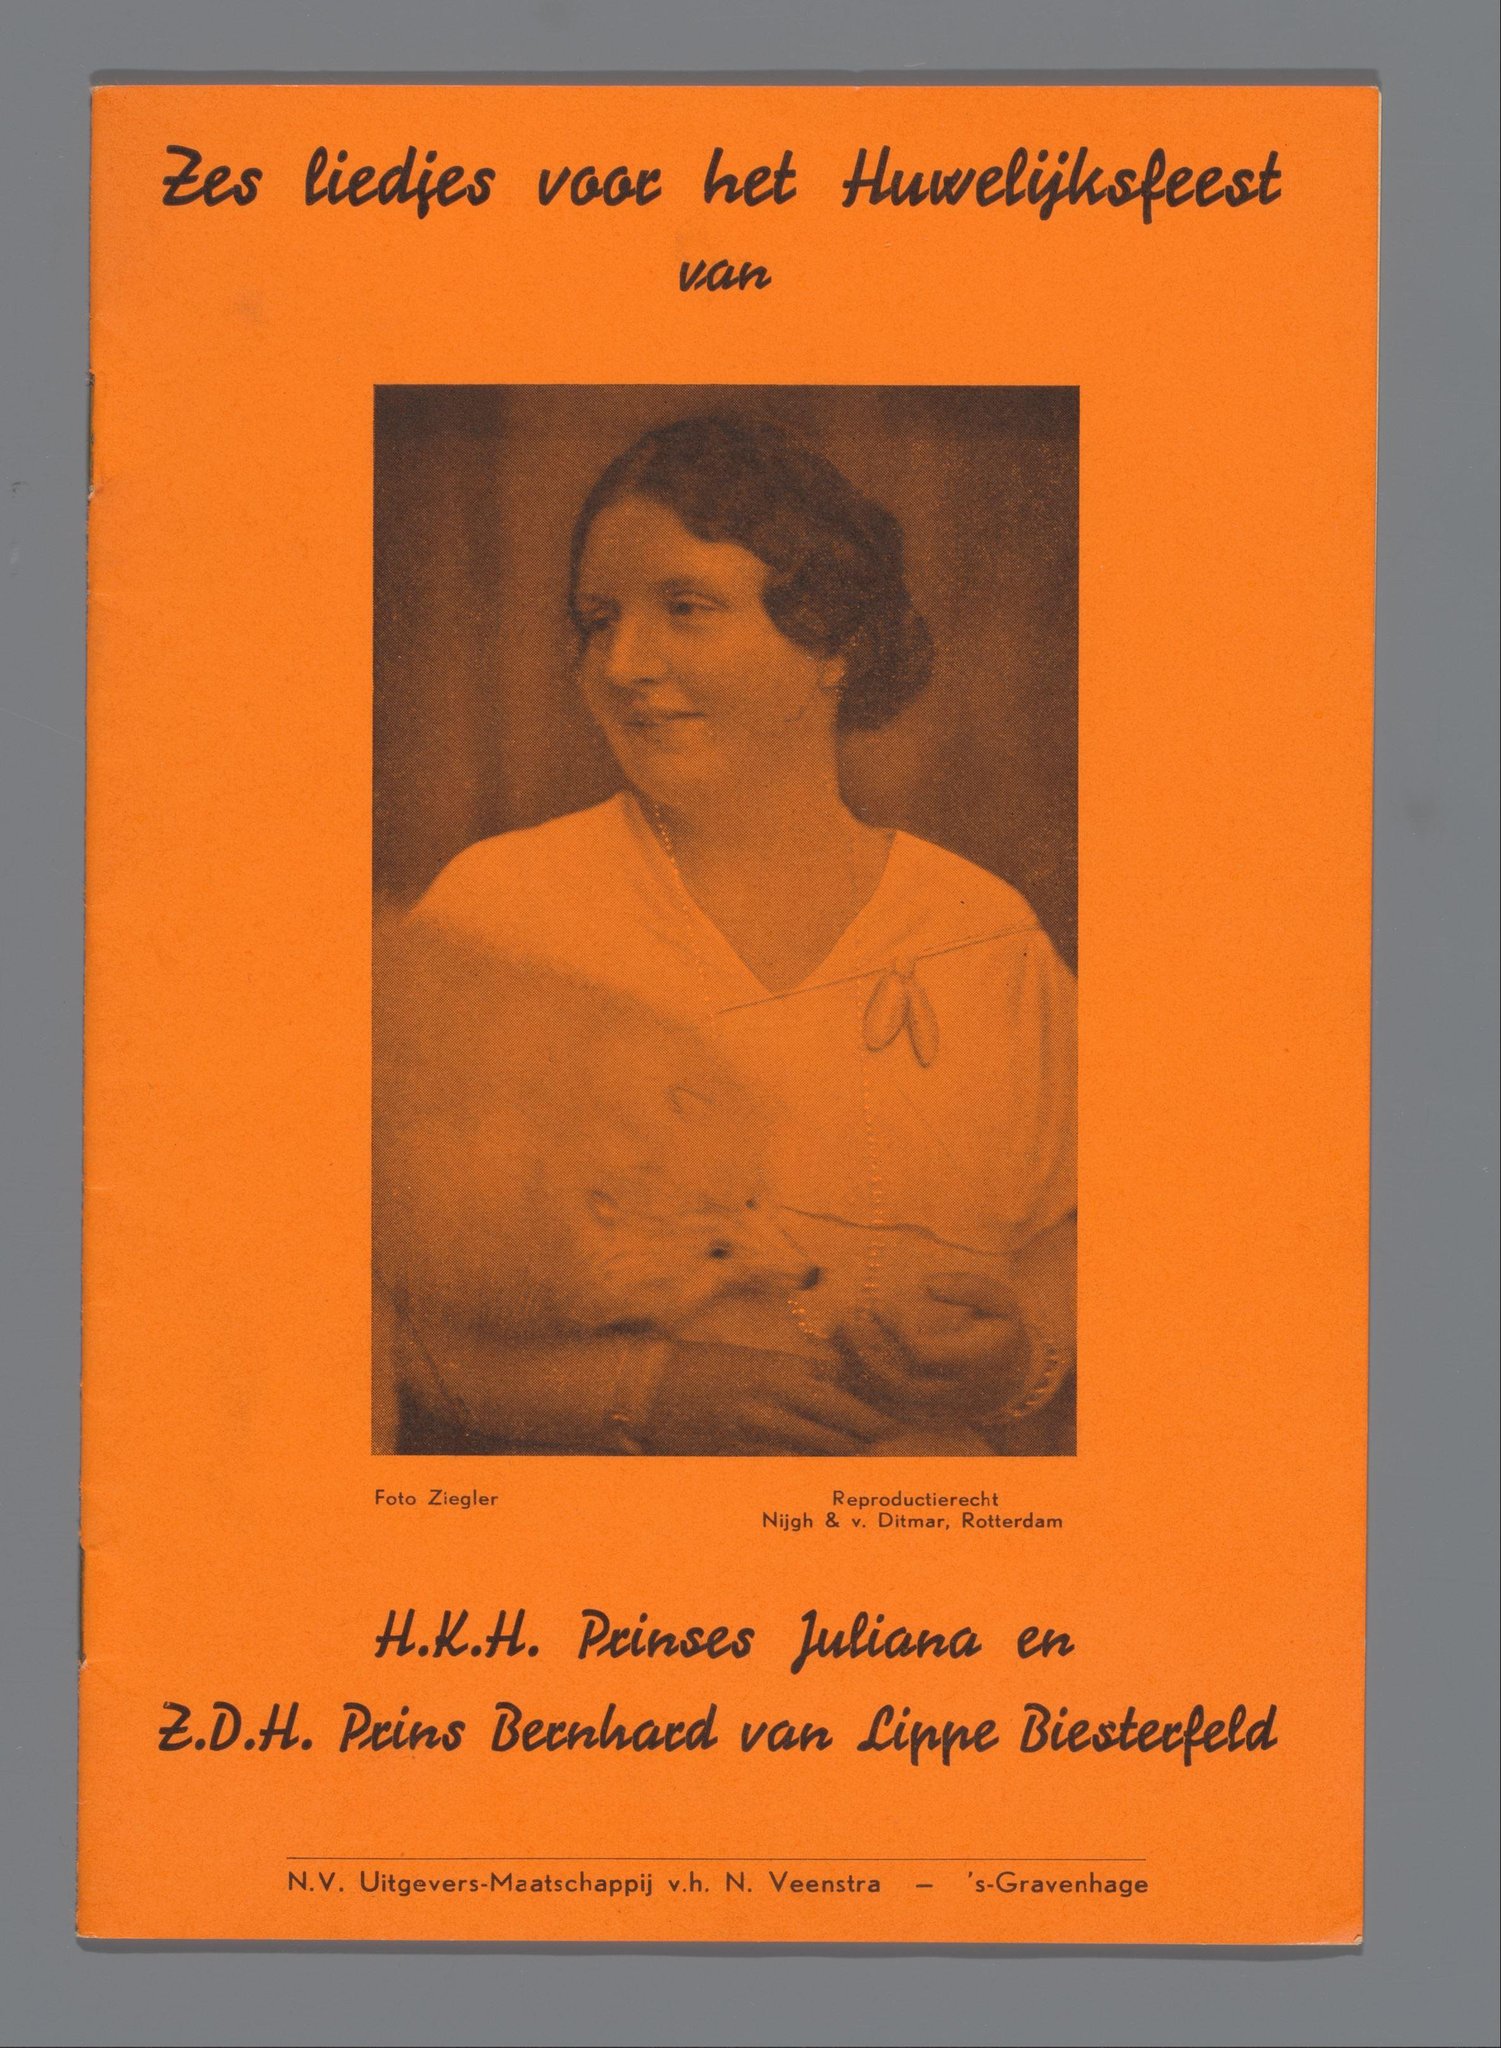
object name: magazine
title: Zes liedjes voor het Huwelijksfeest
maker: n. veenstra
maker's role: publisher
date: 1937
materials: paper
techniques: printing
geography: the hague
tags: utrecht, bernhard (prins der nederlanden), the hague, juliana of the netherlands, netherlands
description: Tijdschrift over het huwelijk van Juliana en Bernhard, 16 pp in oranje omslag.